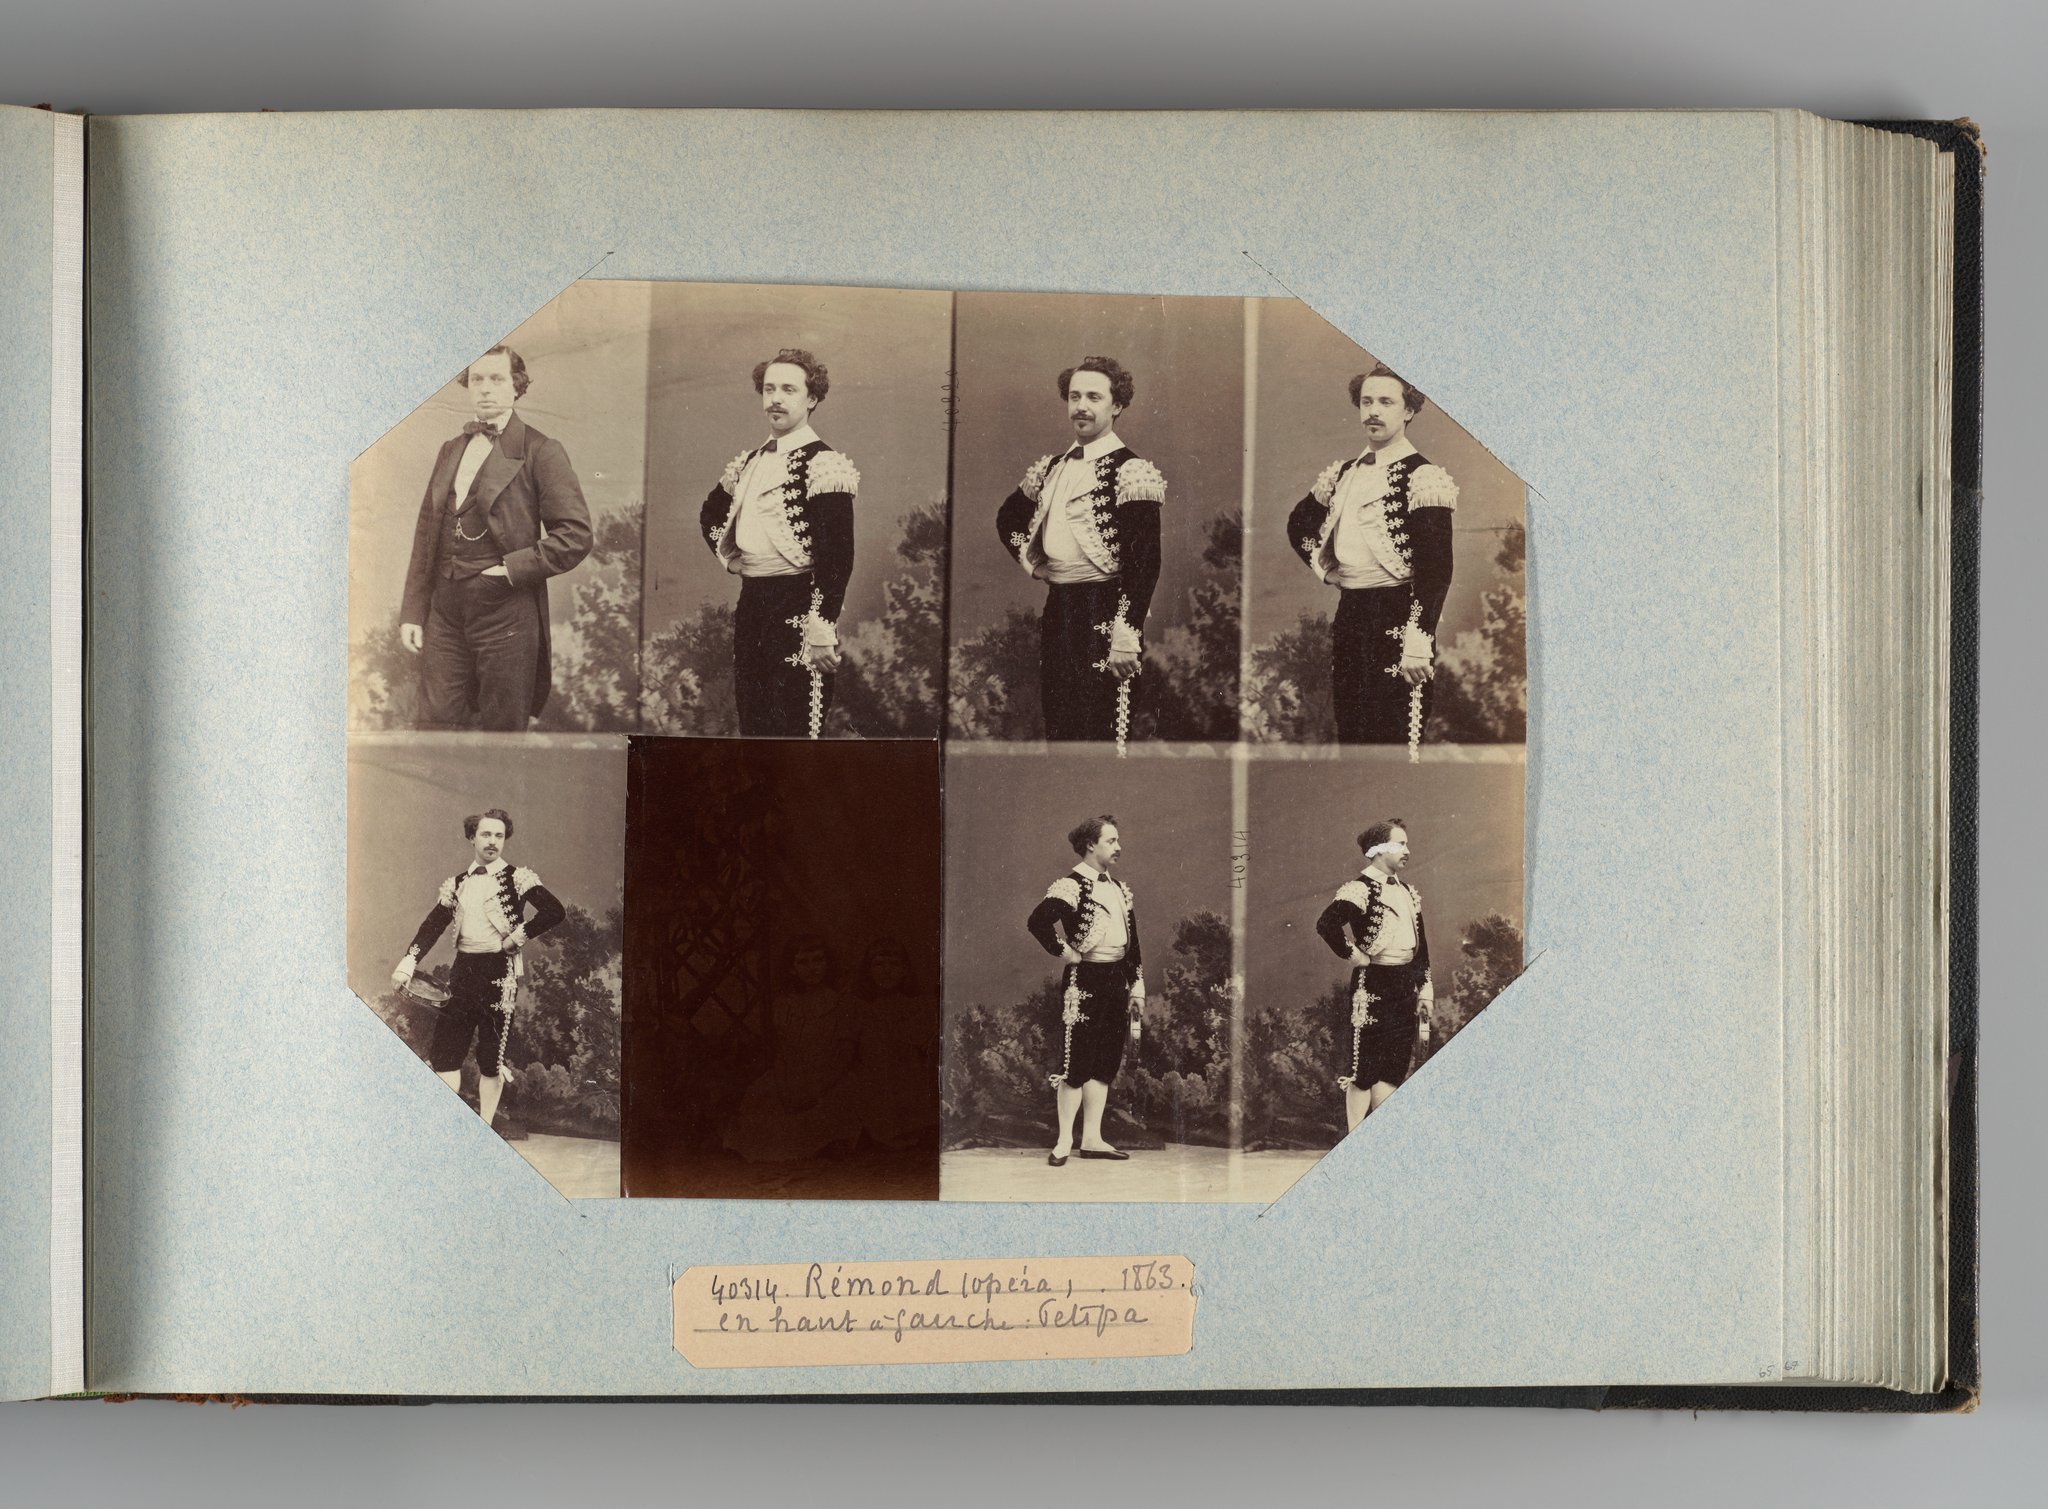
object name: photograph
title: Rémond; Petipa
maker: andré-adolphe-eugène disdéri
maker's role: artist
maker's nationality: french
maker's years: 1819-1889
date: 1863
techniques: albumen silver print, glass negative